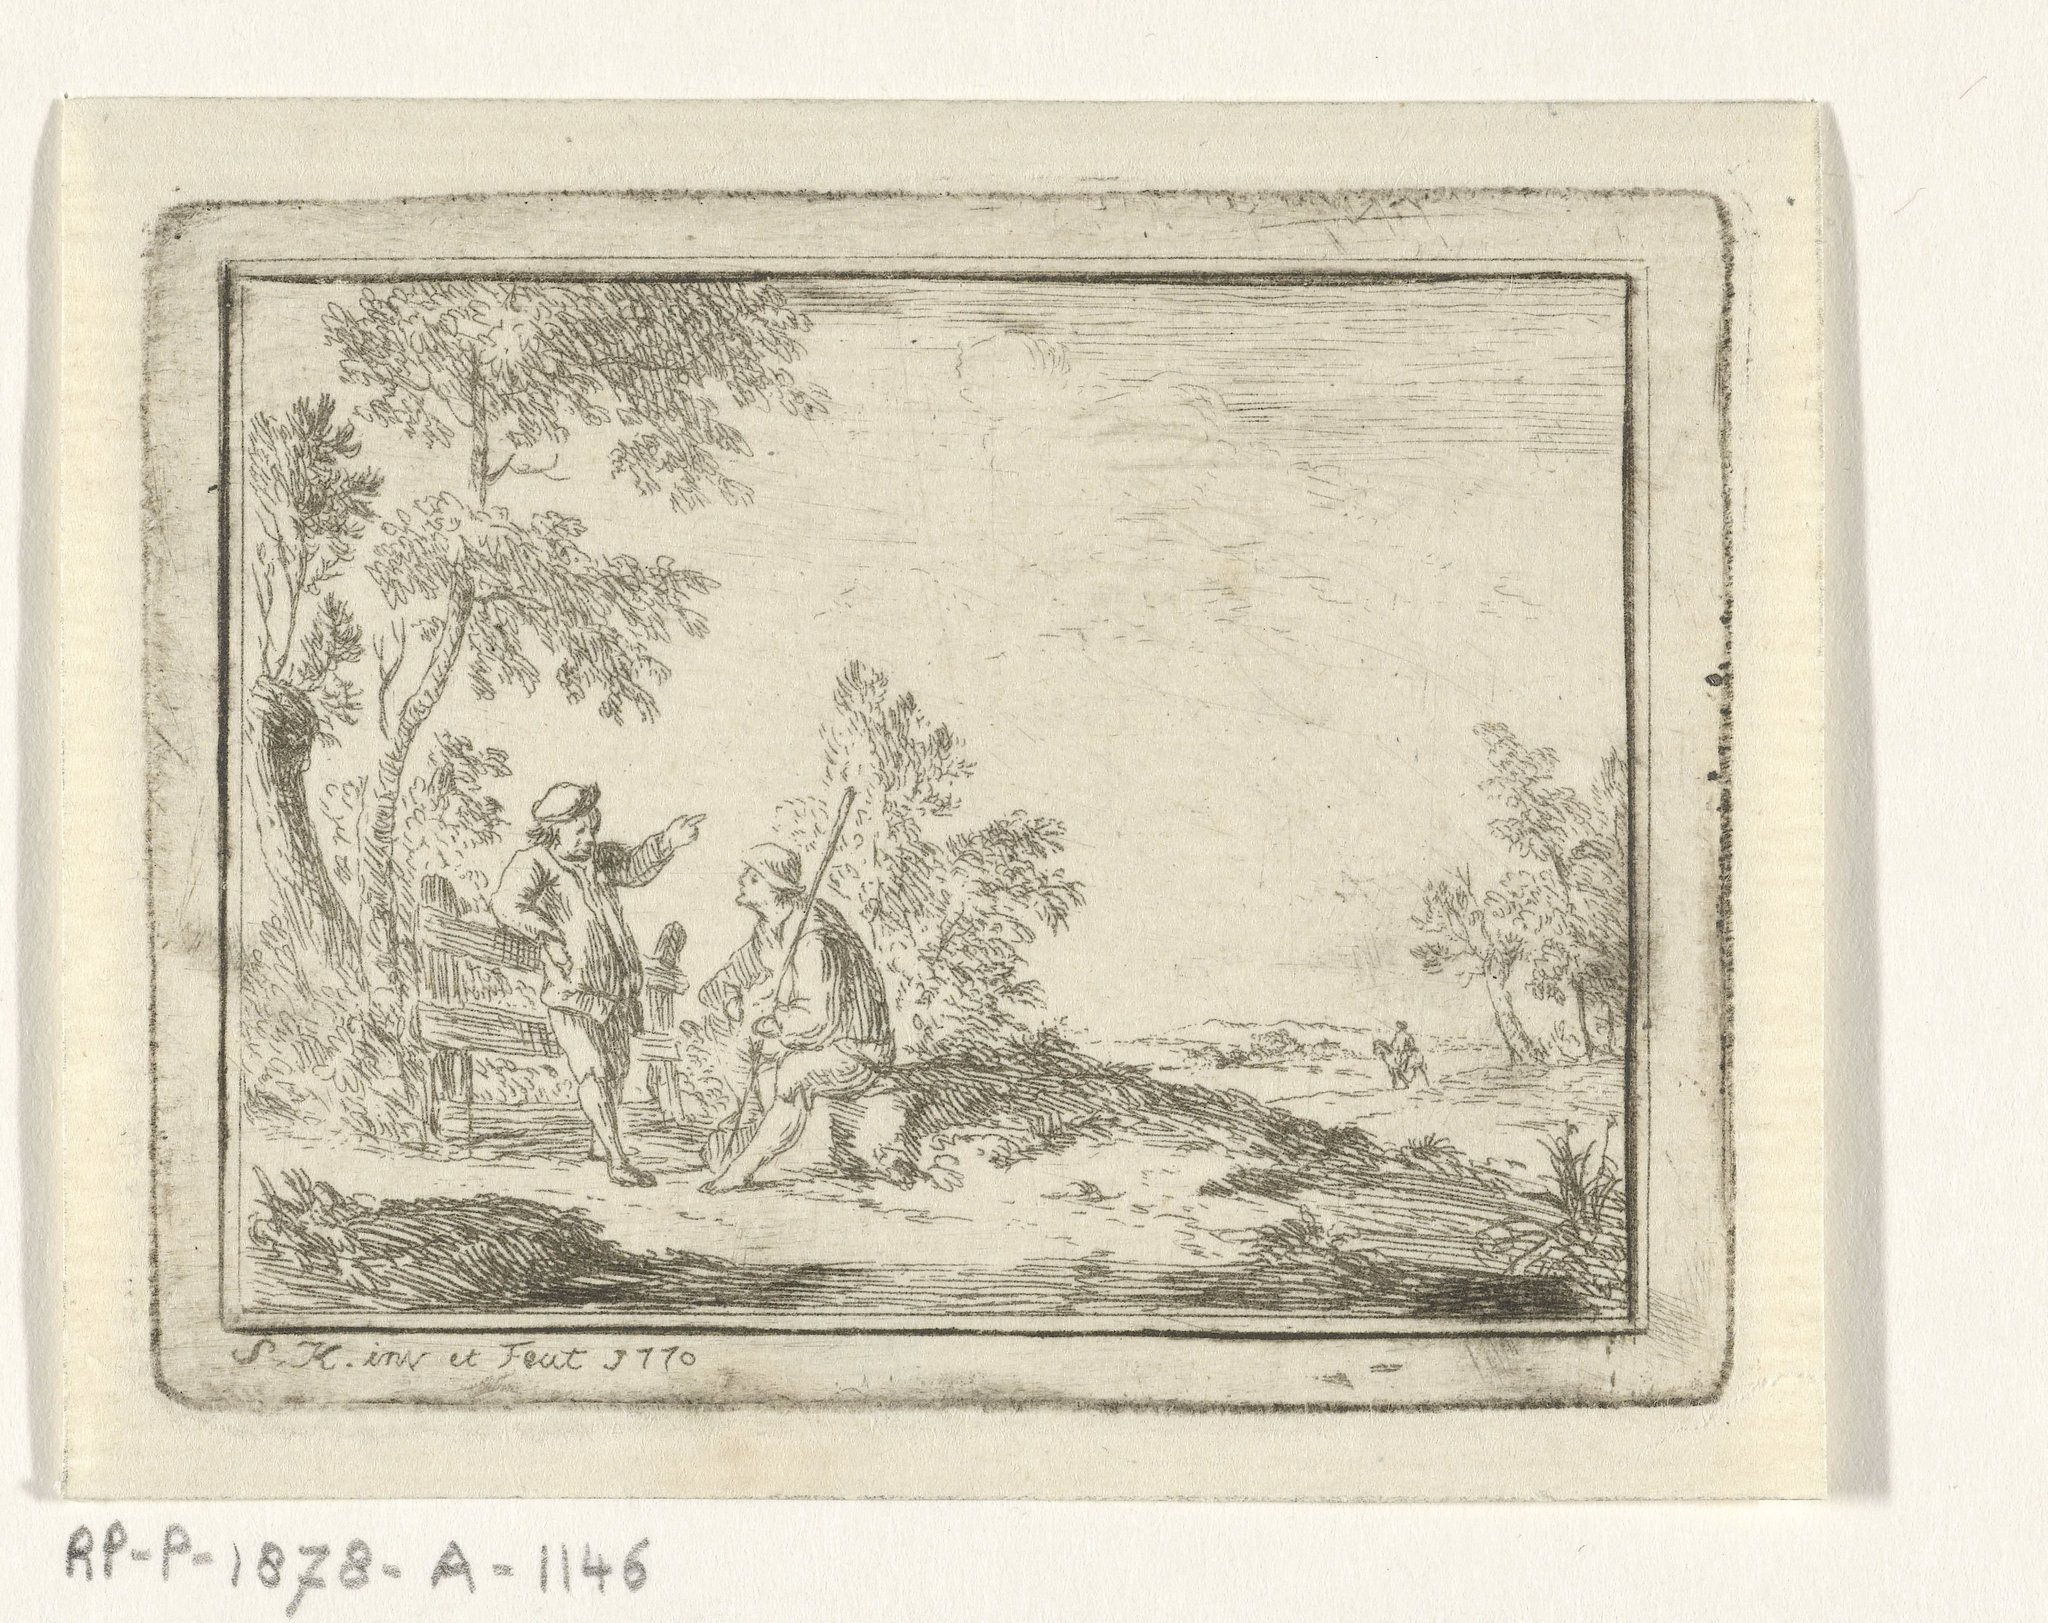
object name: print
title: Landschap met boer en herder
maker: simon klapmuts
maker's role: print maker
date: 1770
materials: paper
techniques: etching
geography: moordrecht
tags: riding a horse, ass, or mule; rider, horseman, landscapes, herding, herdsman, herdswoman, shepherd, shepherdess, cowherd, etc., farmers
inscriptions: collector's mark: Lugt 2227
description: Landschap met op de voorgrond een boer die tegen een hek leunt. Hij is in gesprek met een herder die op een grote steen zit. Op de achtergrond een ruiter.